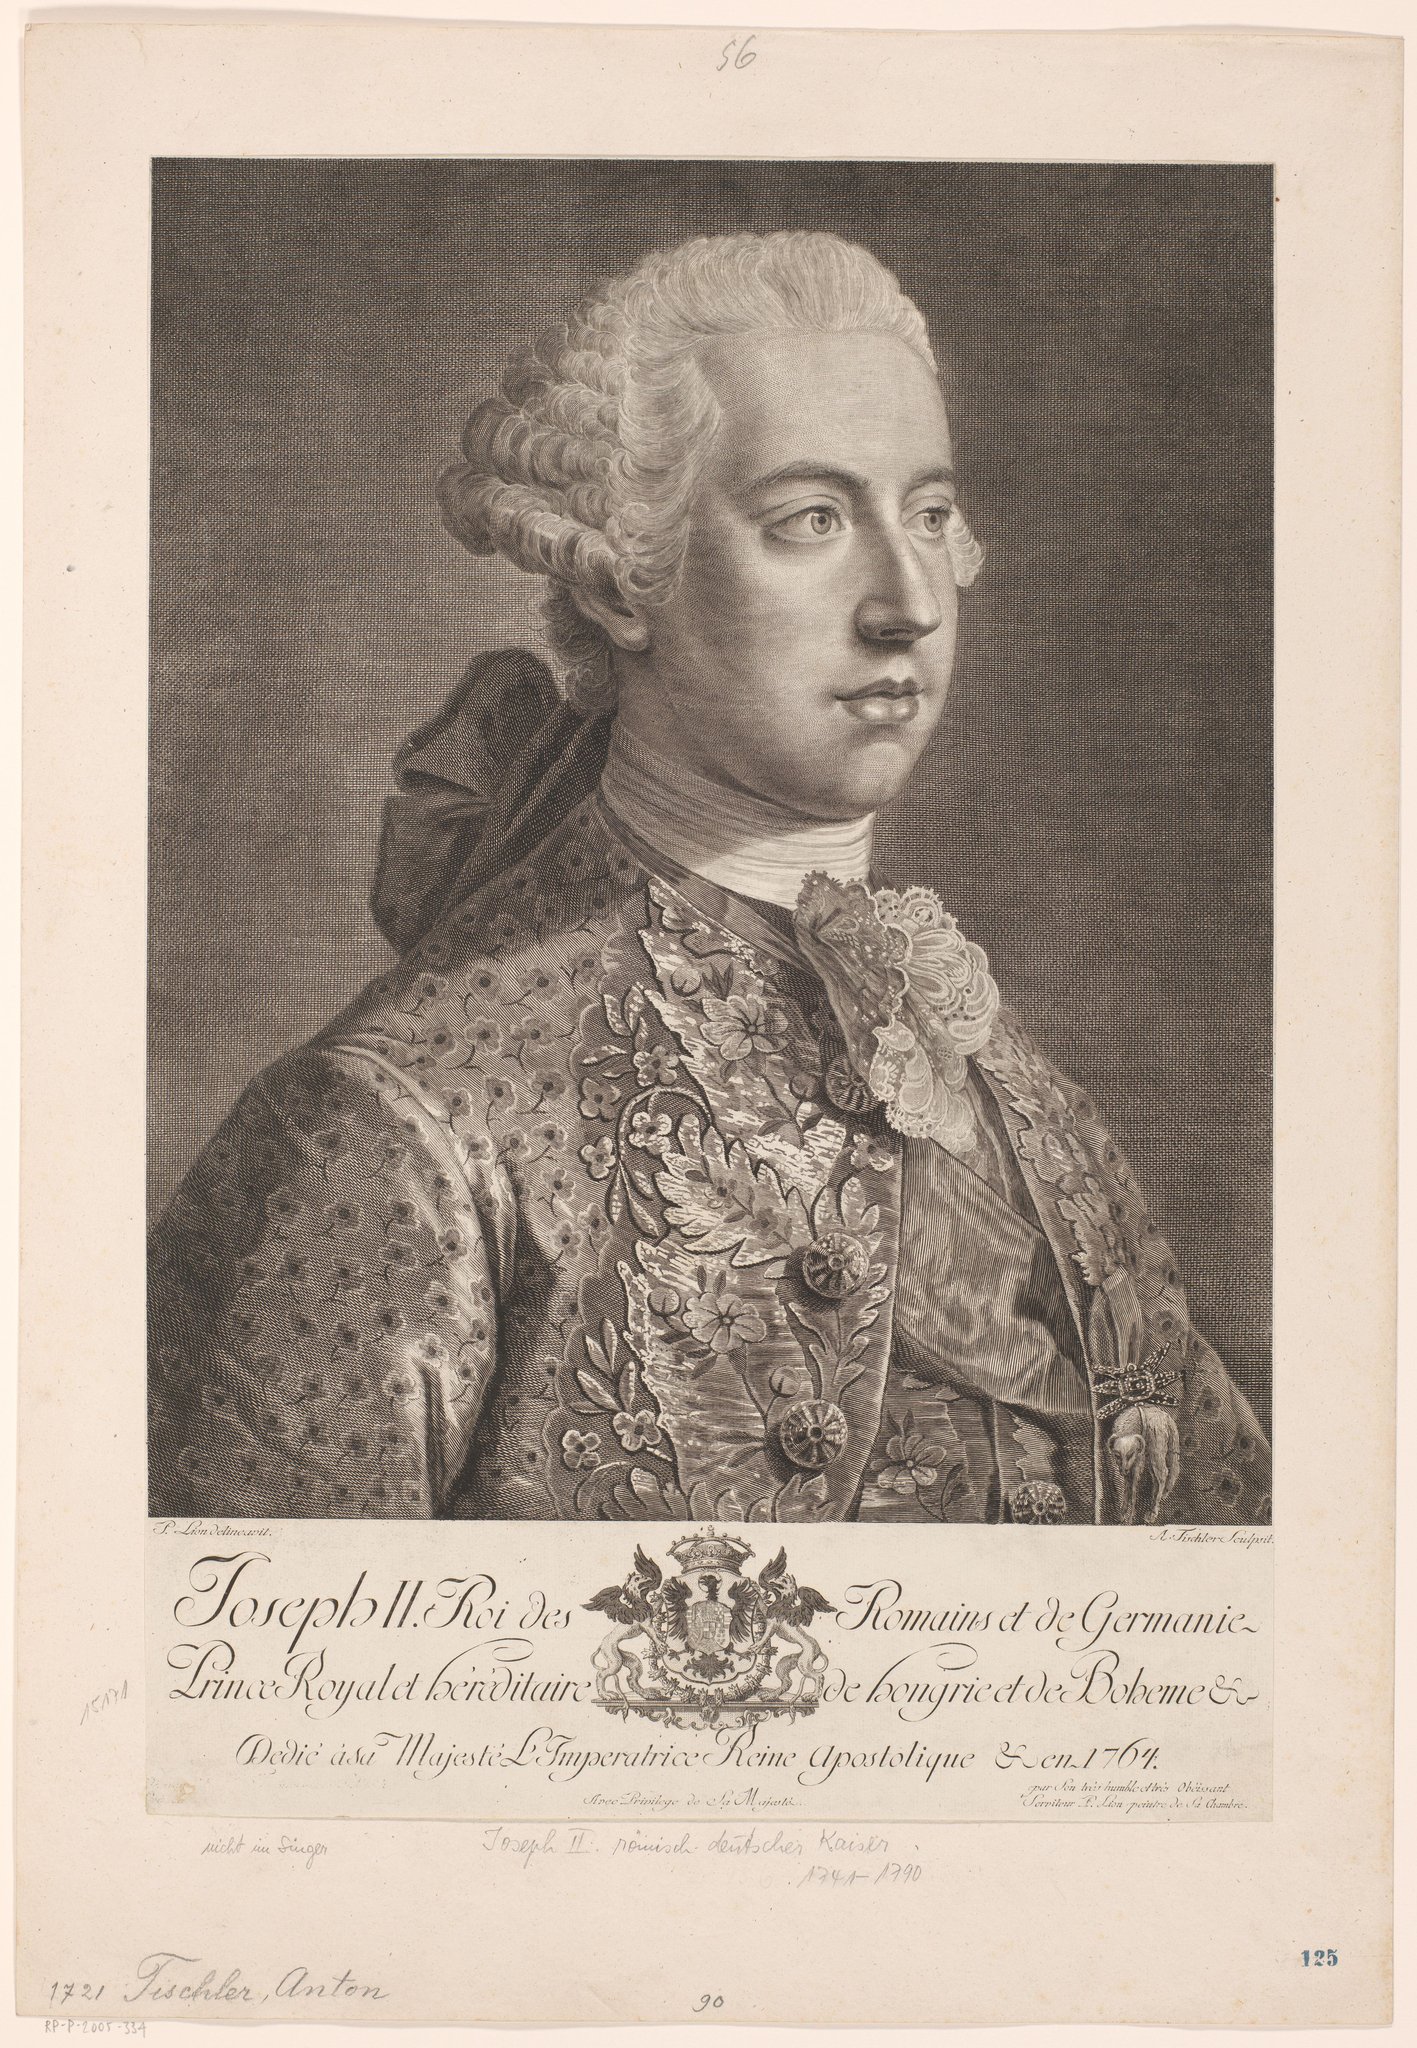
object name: print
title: Portret van keizer Jozef II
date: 1764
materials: paper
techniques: engraving, etching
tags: jozef ii (duits keizer), historical persons, knighthood order of the golden fleece, armorial bearing, heraldry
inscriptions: collector's mark: Lugt 2228, collector's mark: Lugt 2760